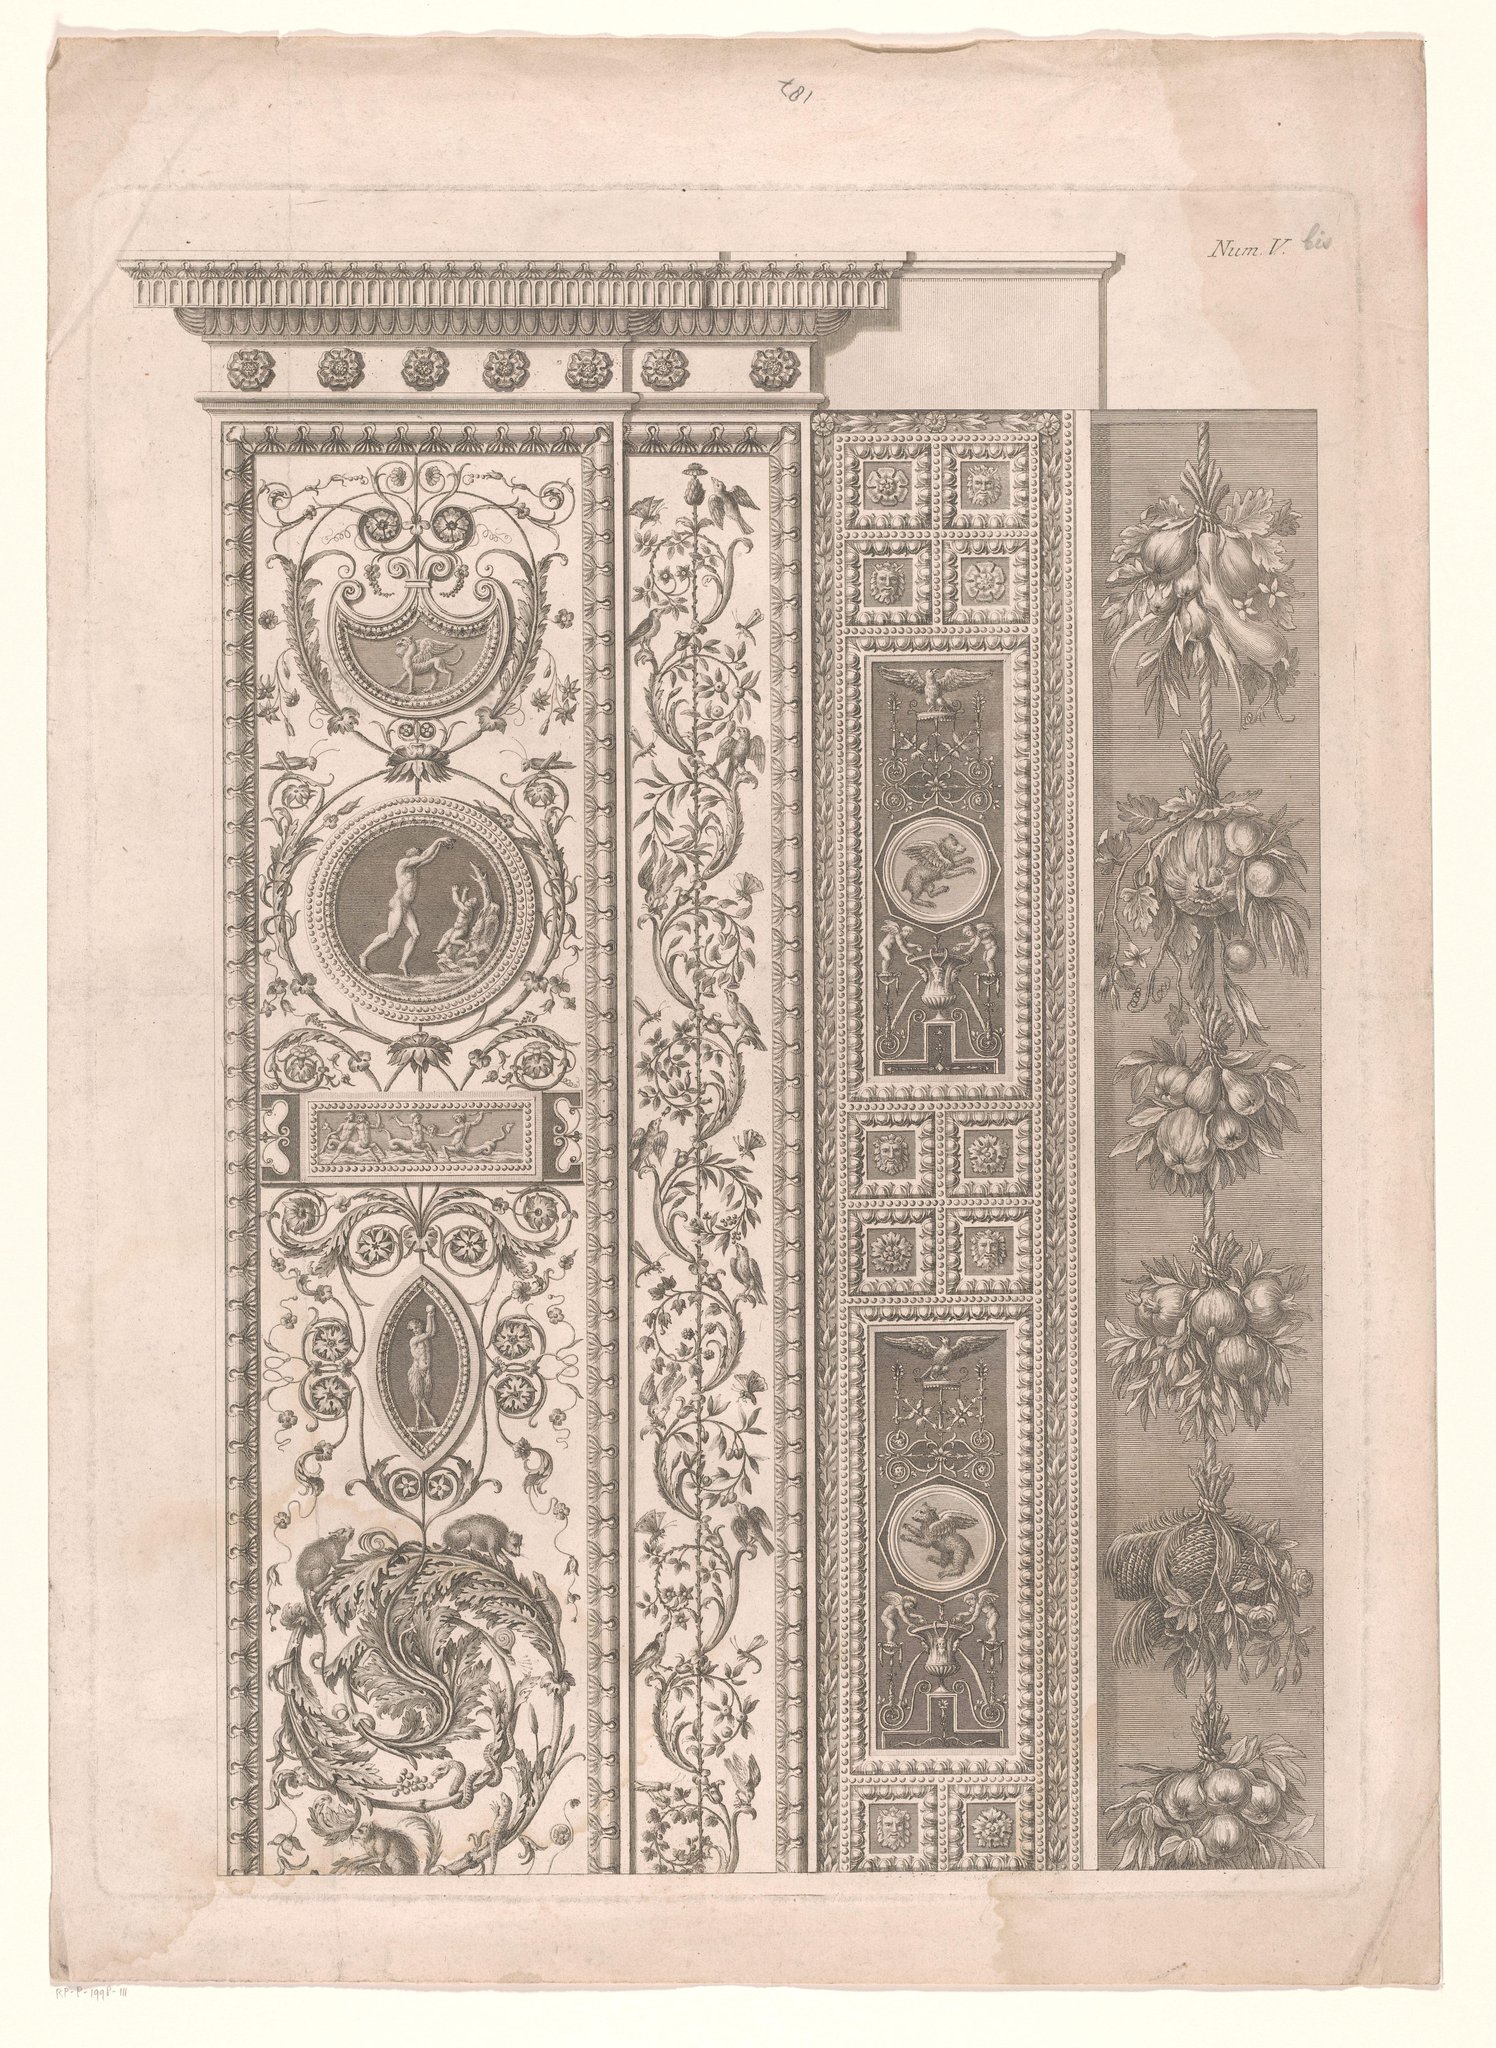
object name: book illustration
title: Bovenste deel van decoratieve pilaster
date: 1772-1779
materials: paper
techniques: engraving, etching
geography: italy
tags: half-column, pilaster ~ architecture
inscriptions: collector's mark: Lugt 2228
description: Links arabesken en medaillons met griffioen en figuren. Rechts tabletten met gevleugelde beren en guirlandes van vruchten. Bovenste deel van een pilaster. Rechts boven genummerd IV.